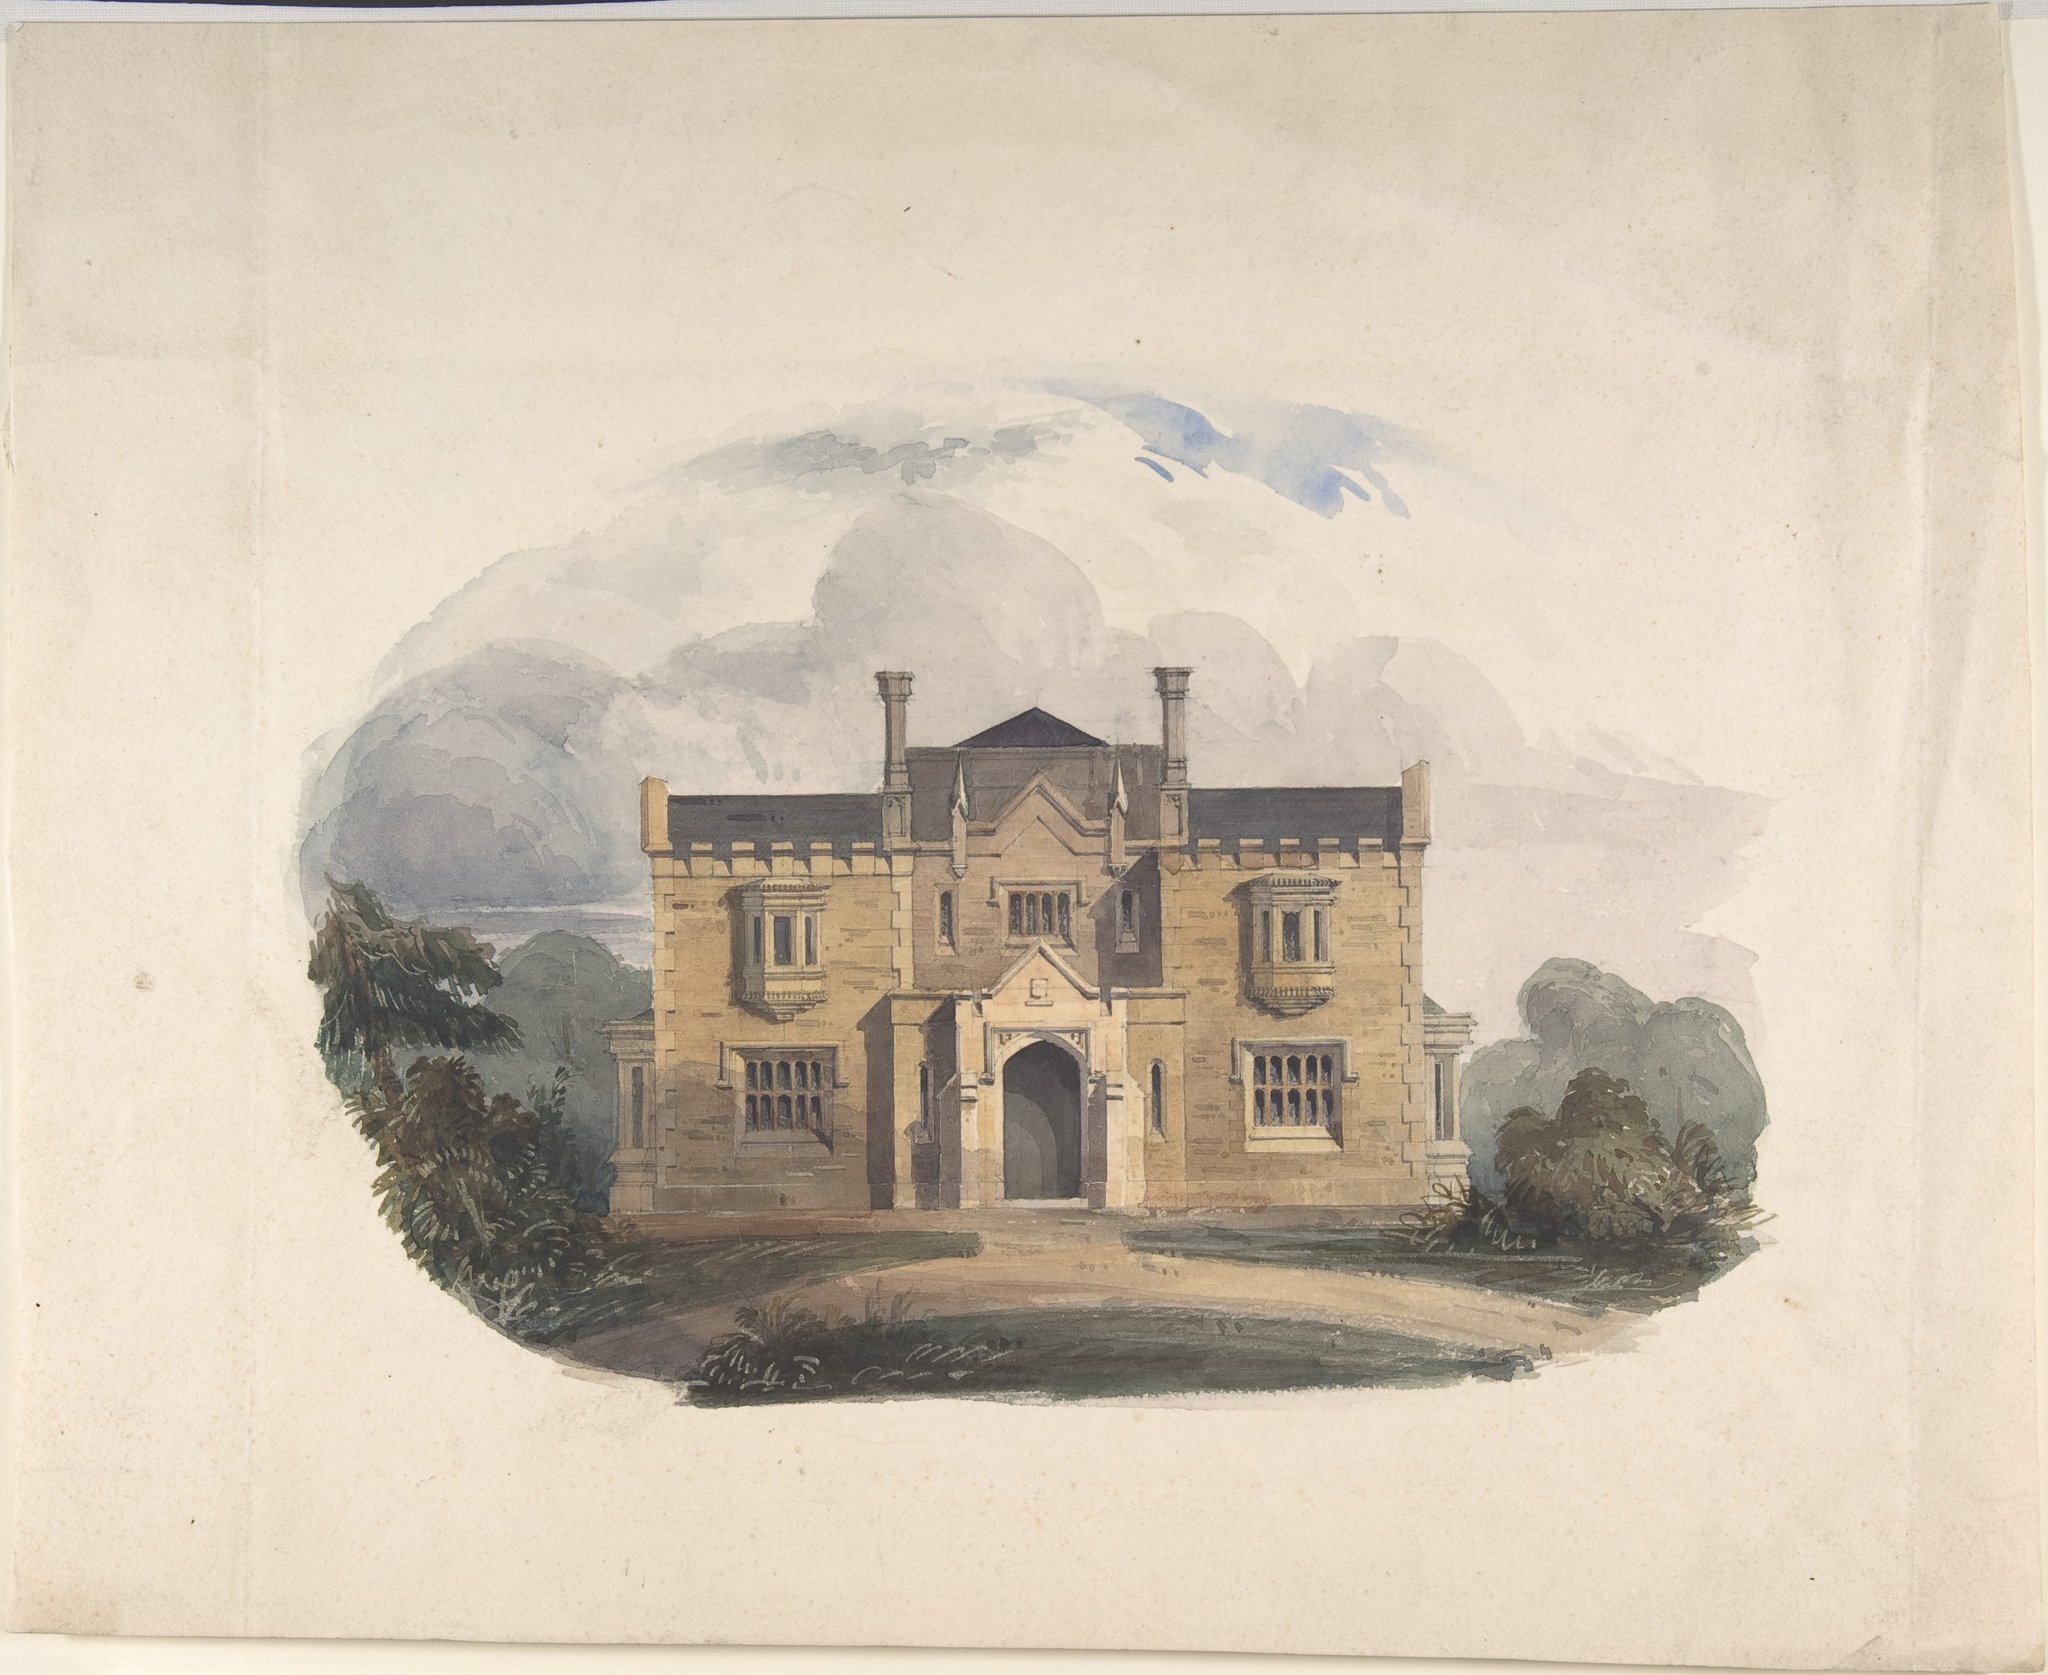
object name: drawing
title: Design for a Tudoresque Villa, Elevation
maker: anonymous, british, early 19th century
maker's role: artist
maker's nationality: british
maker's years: 1800-1850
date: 1801-1900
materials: ink, watercolor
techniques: pen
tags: houses